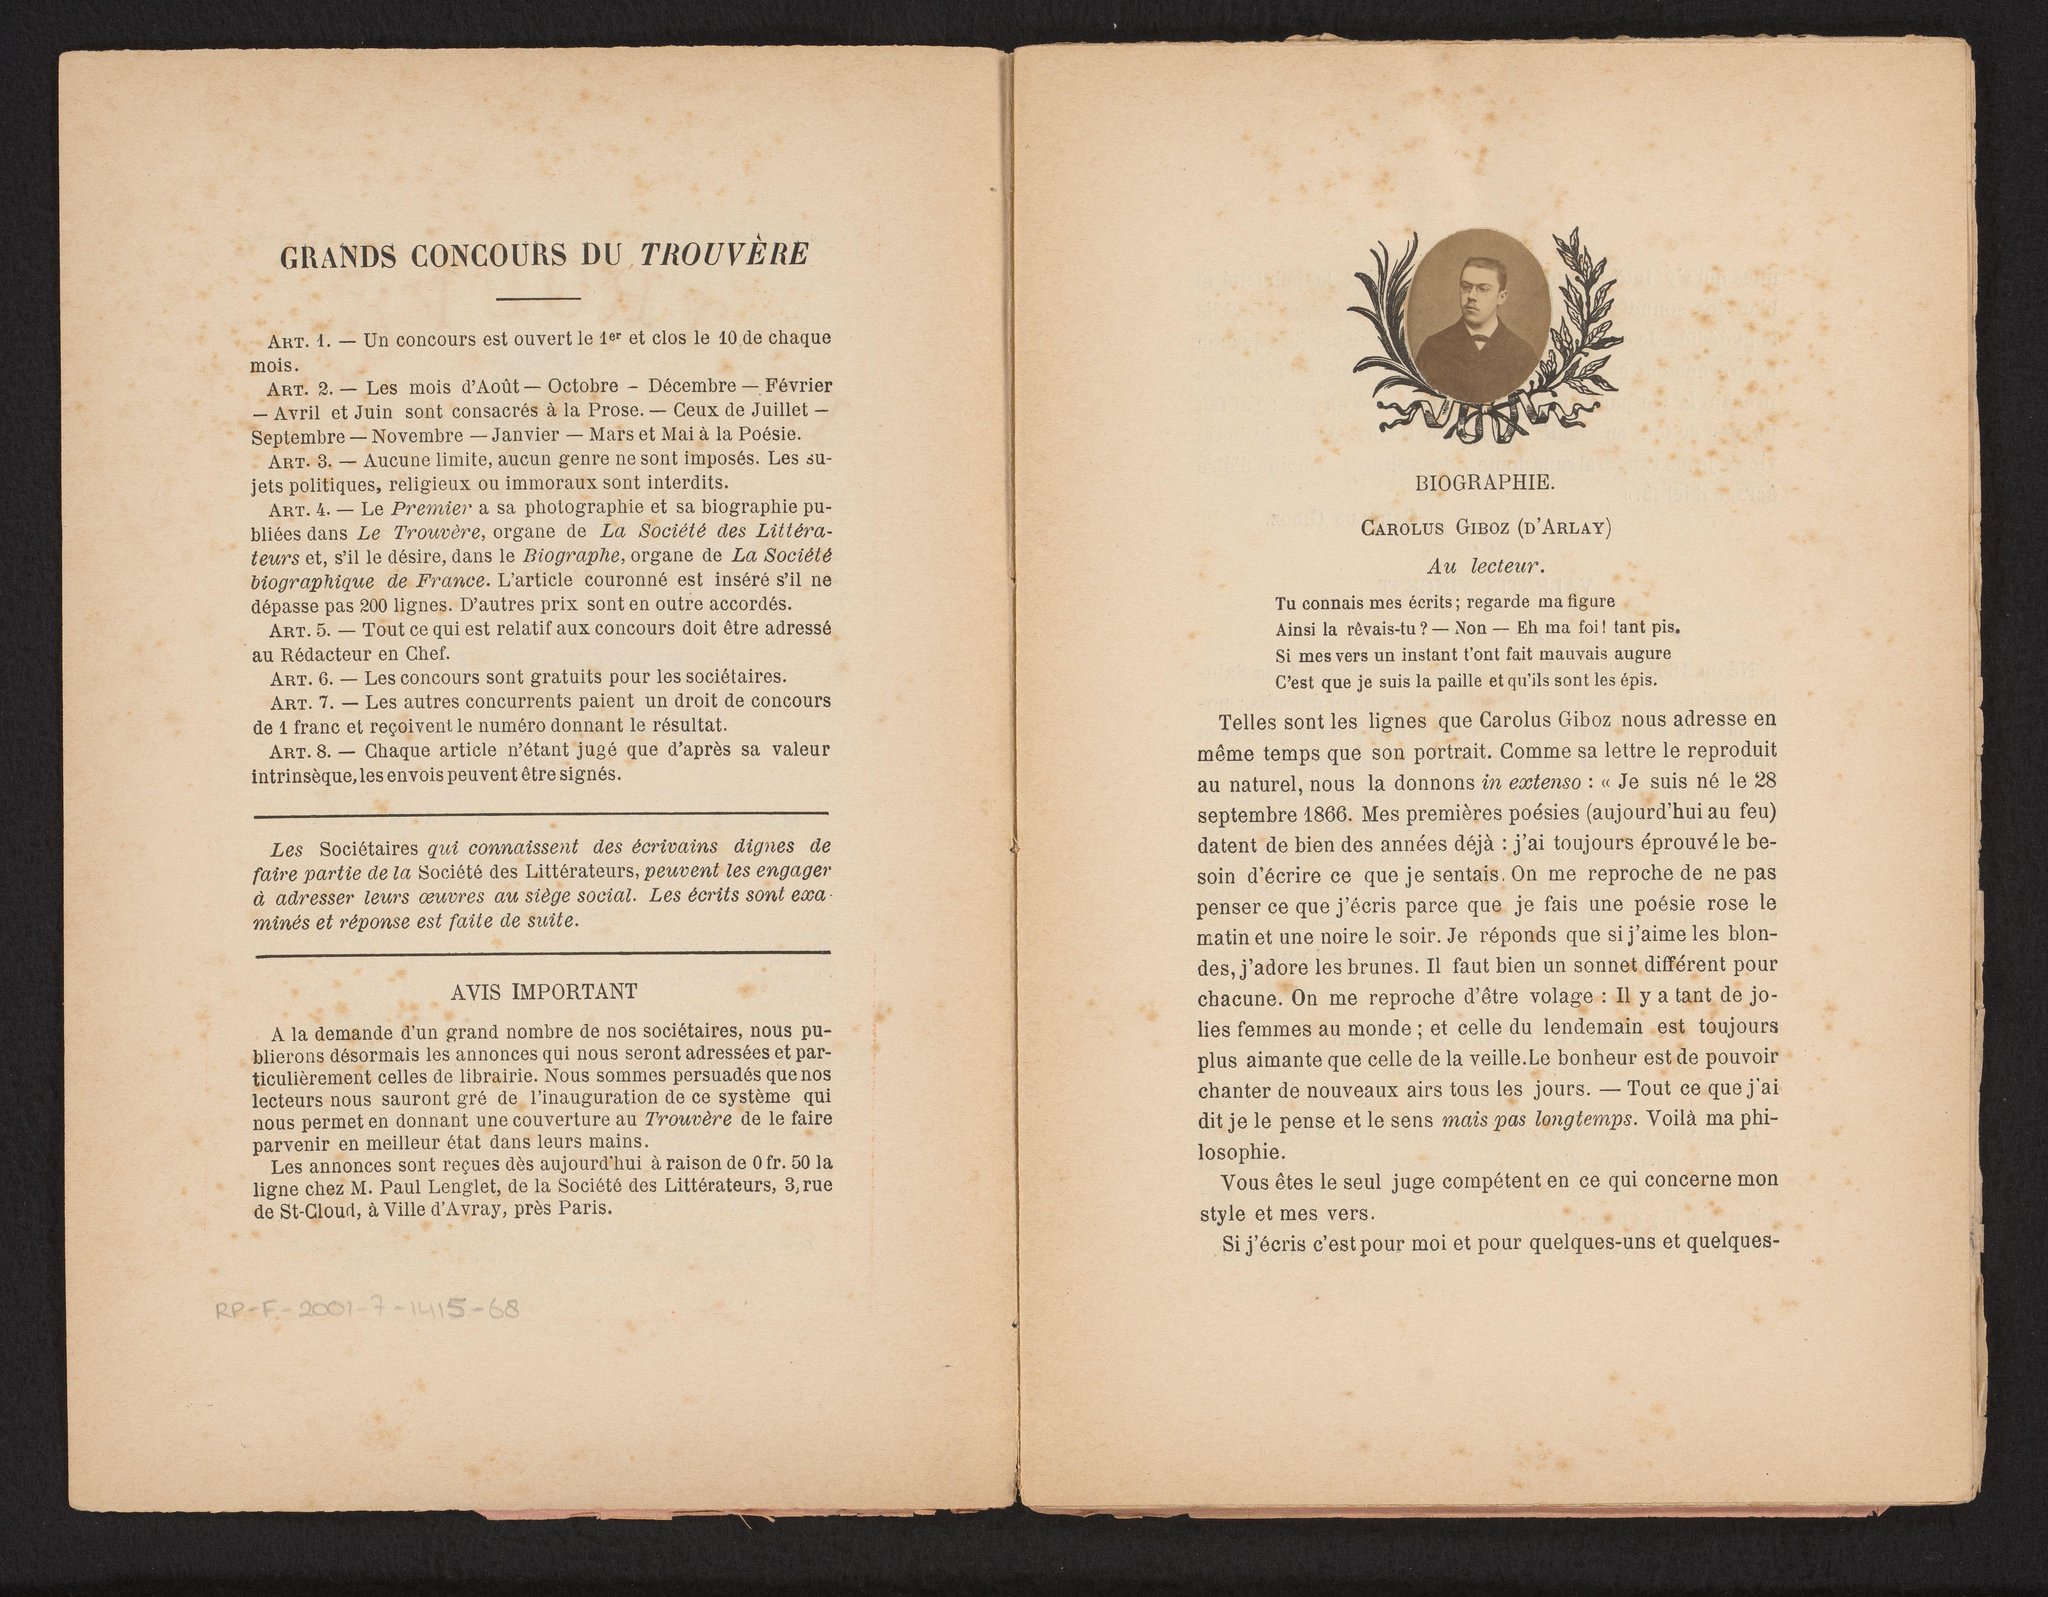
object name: photograph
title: Portret van Carolus Giboz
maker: Anonymous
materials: photographic support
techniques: albumen print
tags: historical persons